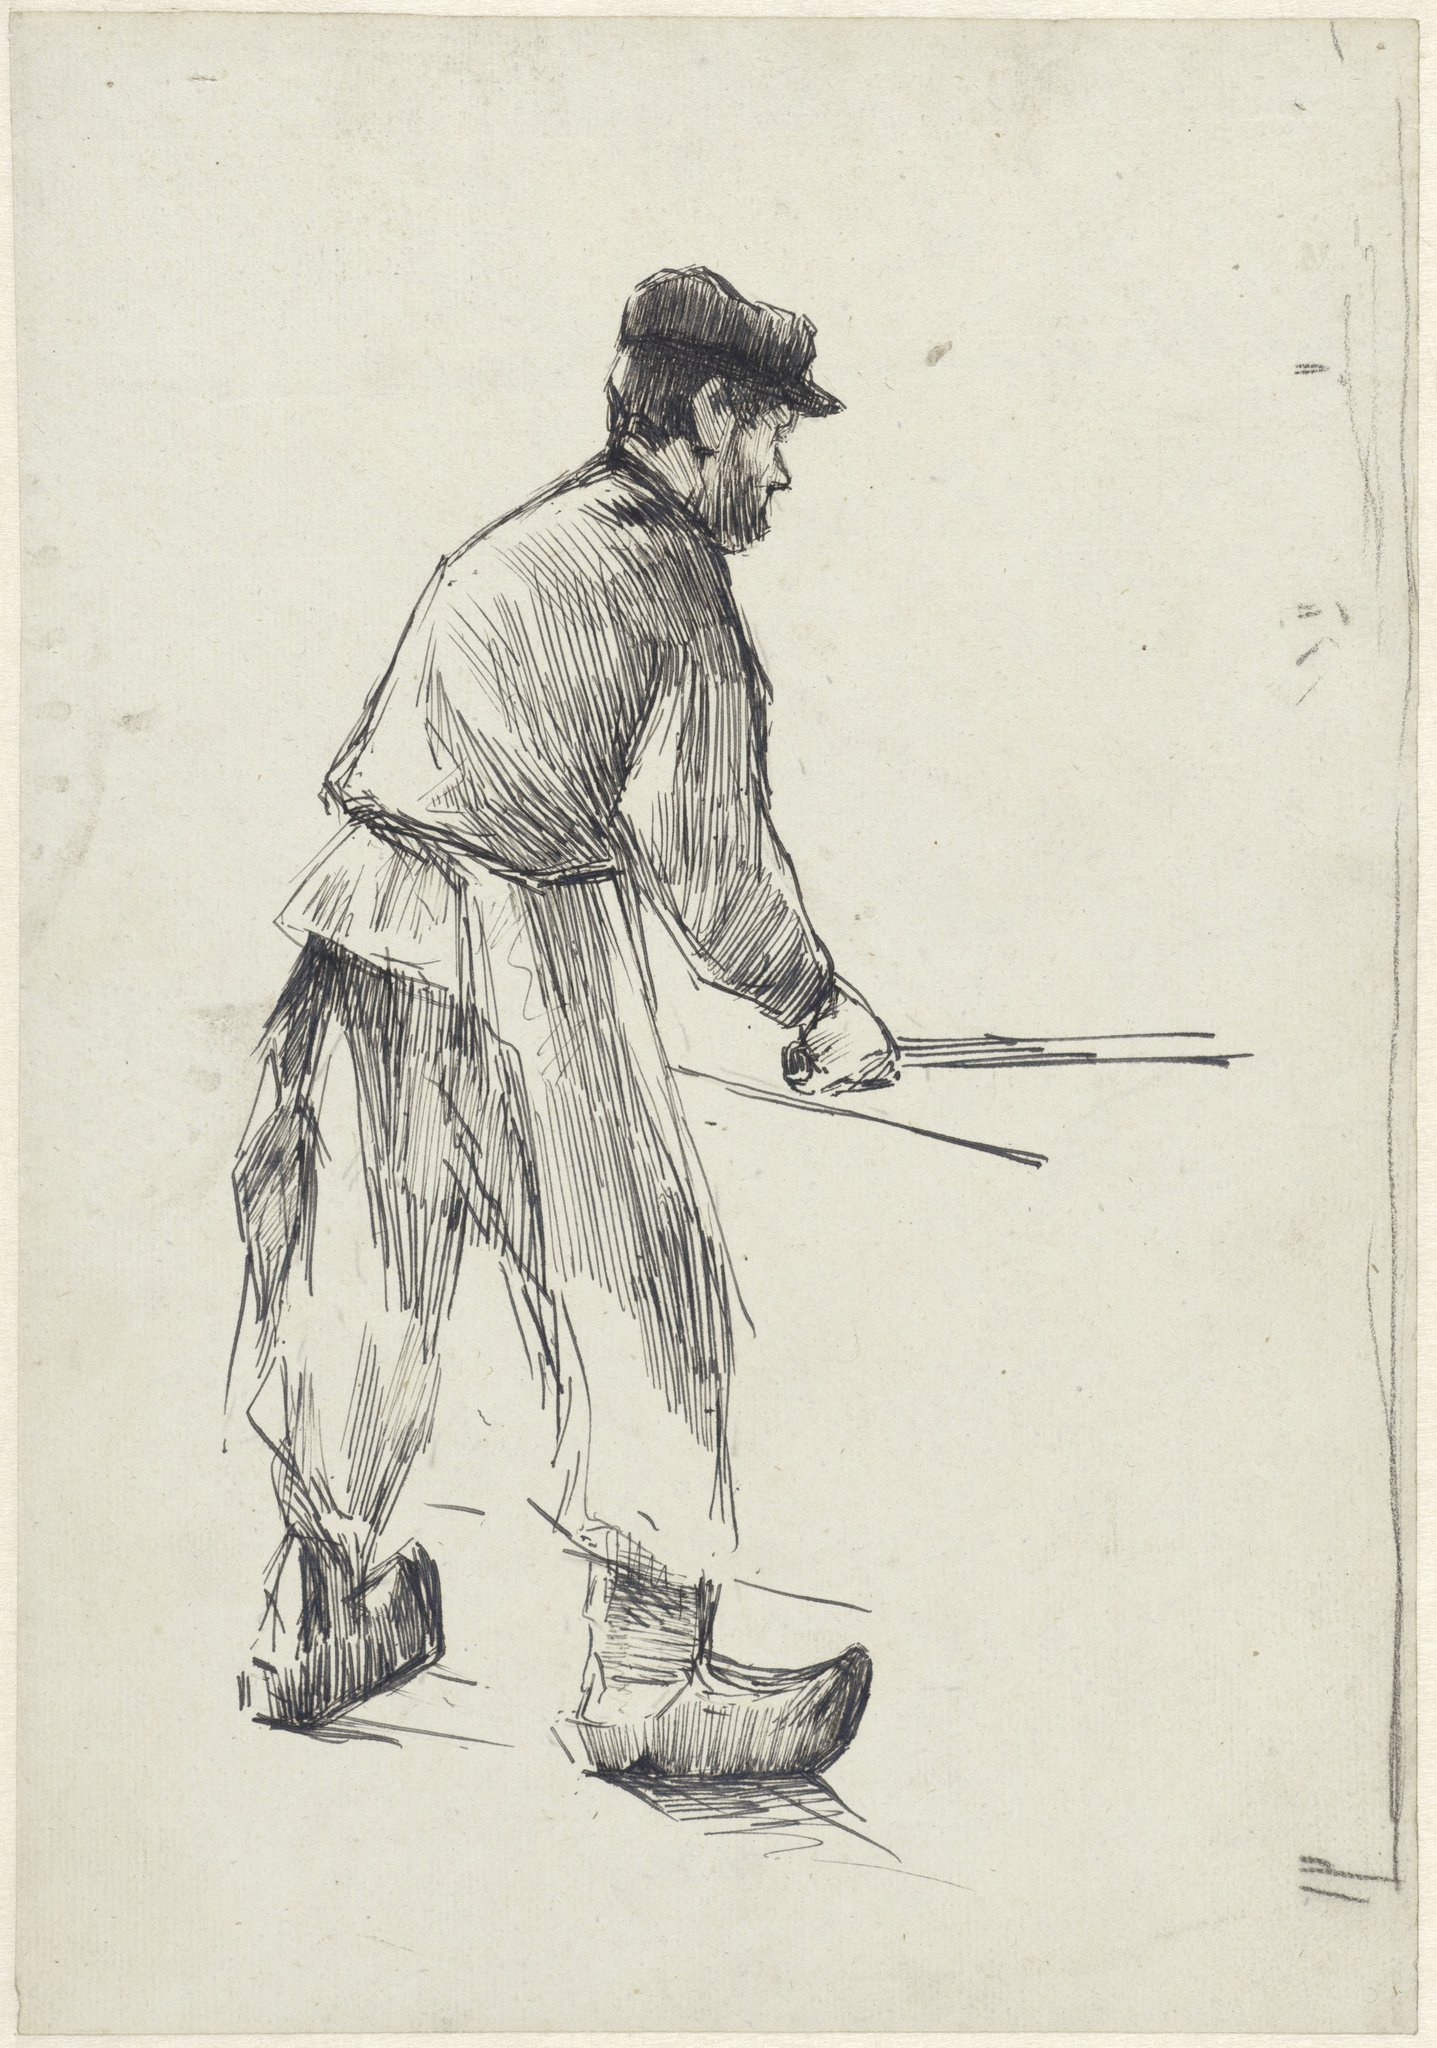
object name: drawing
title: Werkman in de katoenververij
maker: anthon gerhard alexander van rappard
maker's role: draughtsman, print maker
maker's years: 1858-1892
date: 1868-1892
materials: ink, paper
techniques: pen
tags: dyeing of cloth